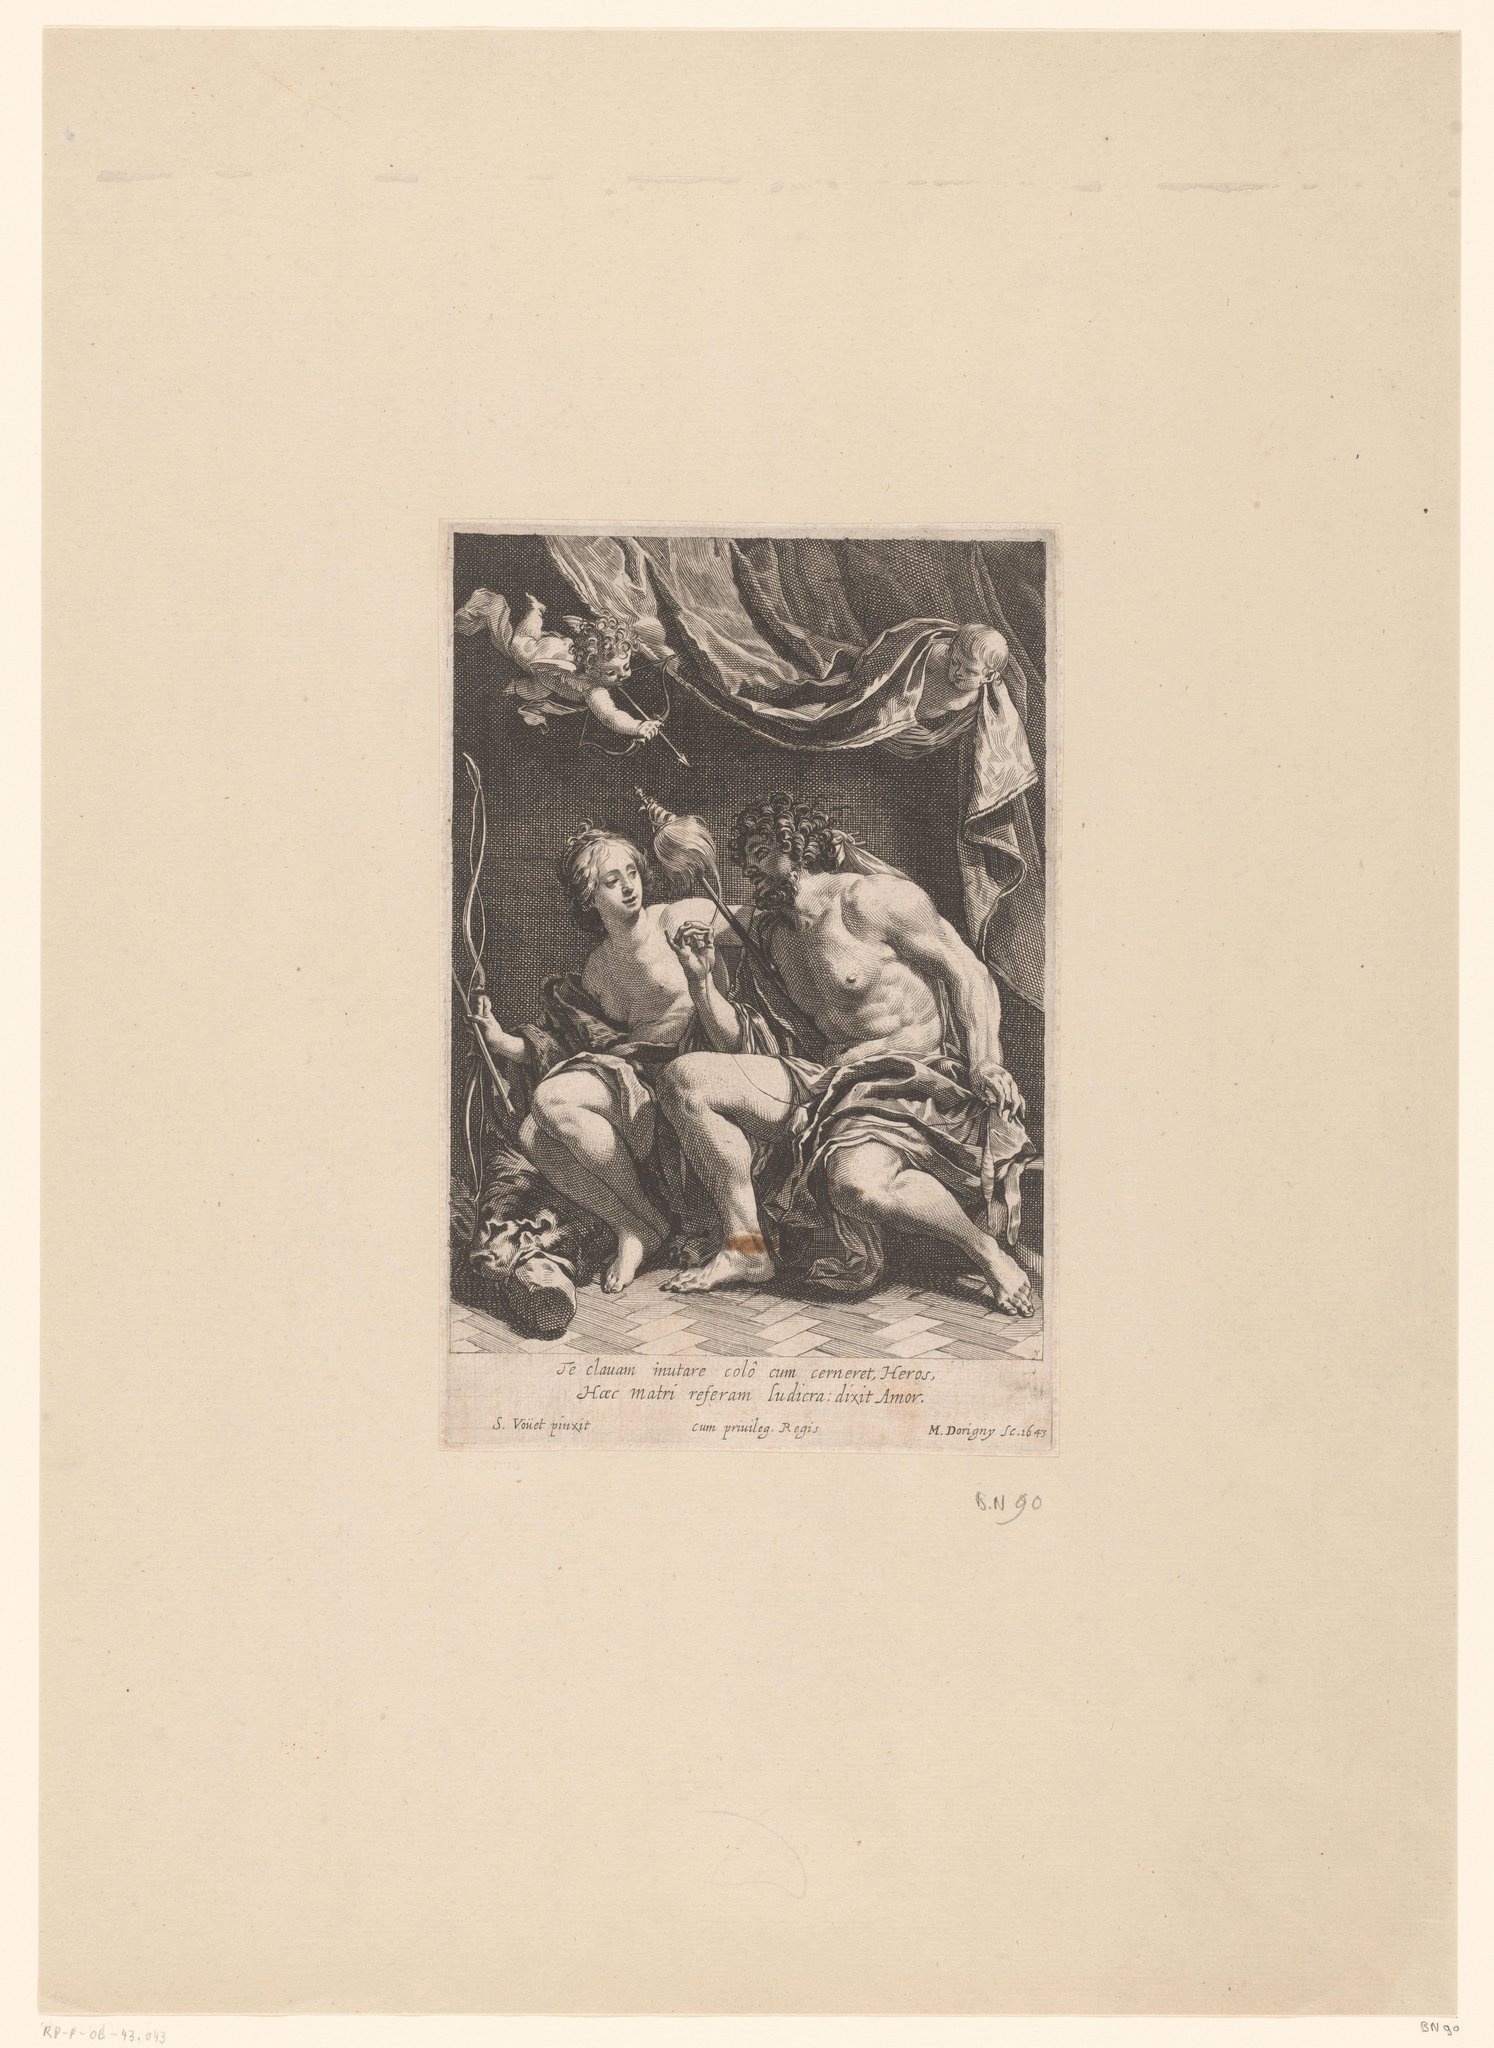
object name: print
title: Hercules en Omphale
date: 1643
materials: paper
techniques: engraving, etching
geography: france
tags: hercules in love with omphale; the hero is set to spin wool or to do other women's work among the servants, while omphale wears his lion's skin and wields his club and bow, (story of) cupid, amor (eros)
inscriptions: collector's mark: Lugt 240